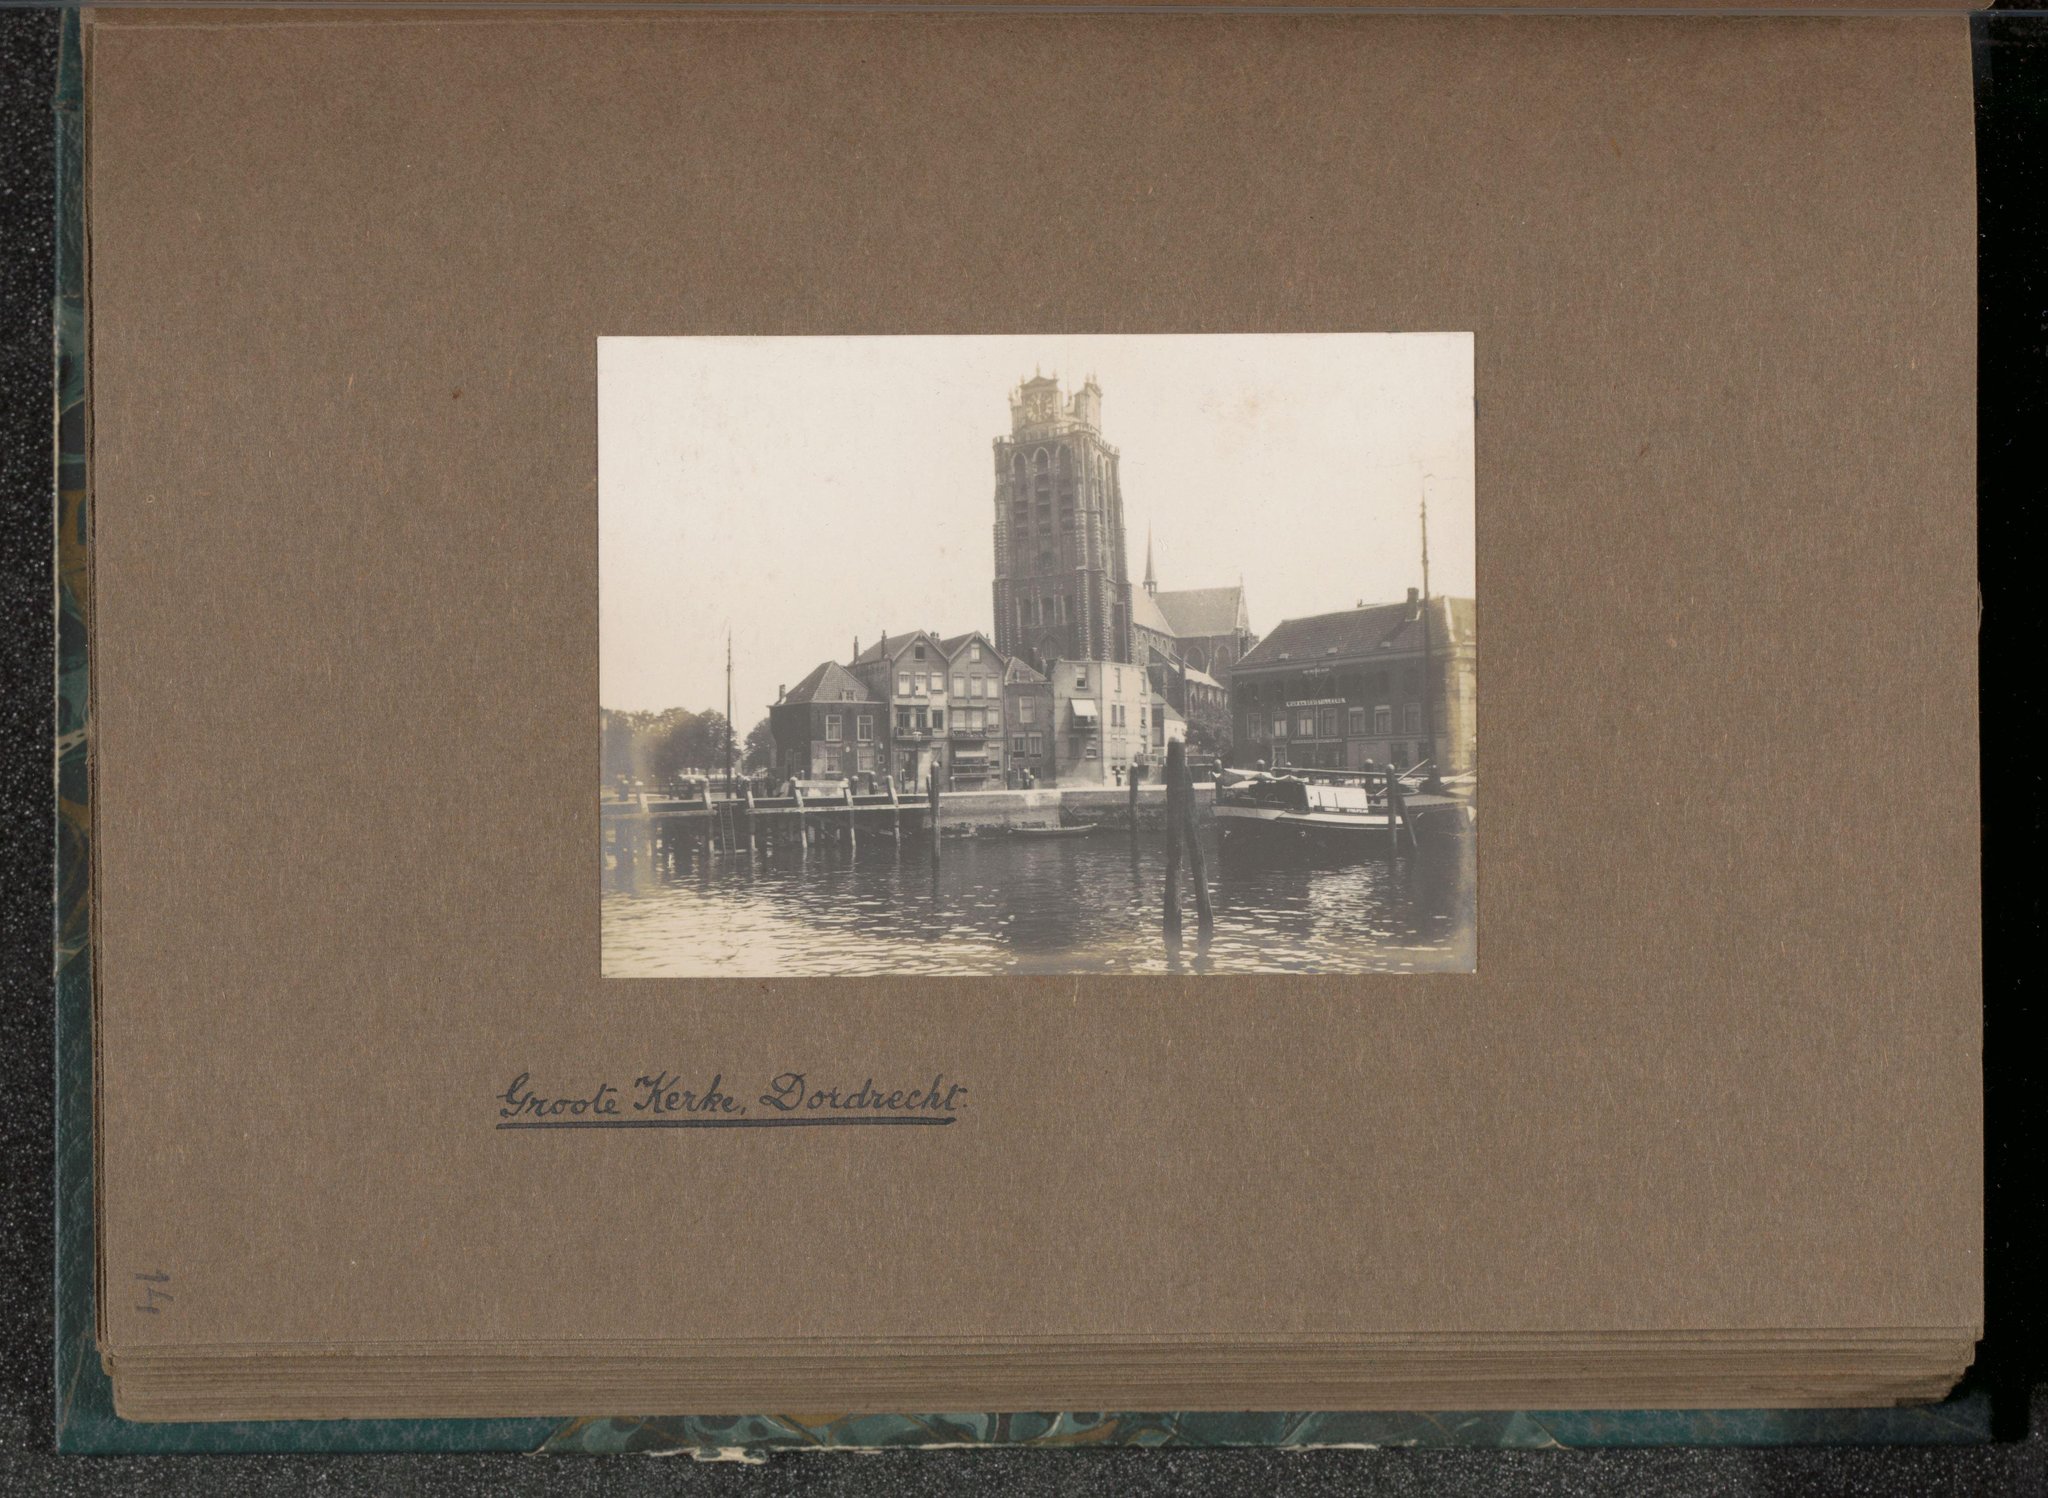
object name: photograph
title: Groote Kerke Dordrecht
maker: Anonymous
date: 1912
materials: photographic support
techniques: gelatin silver print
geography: dordrecht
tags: canal, travelling; tourism, parts of church exterior and annexes: tower, dordrecht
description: Onderdeel van Fotoalbum van de excursie naar Nederland van de Britse amateurfotografenvereniging P.C.U.K.